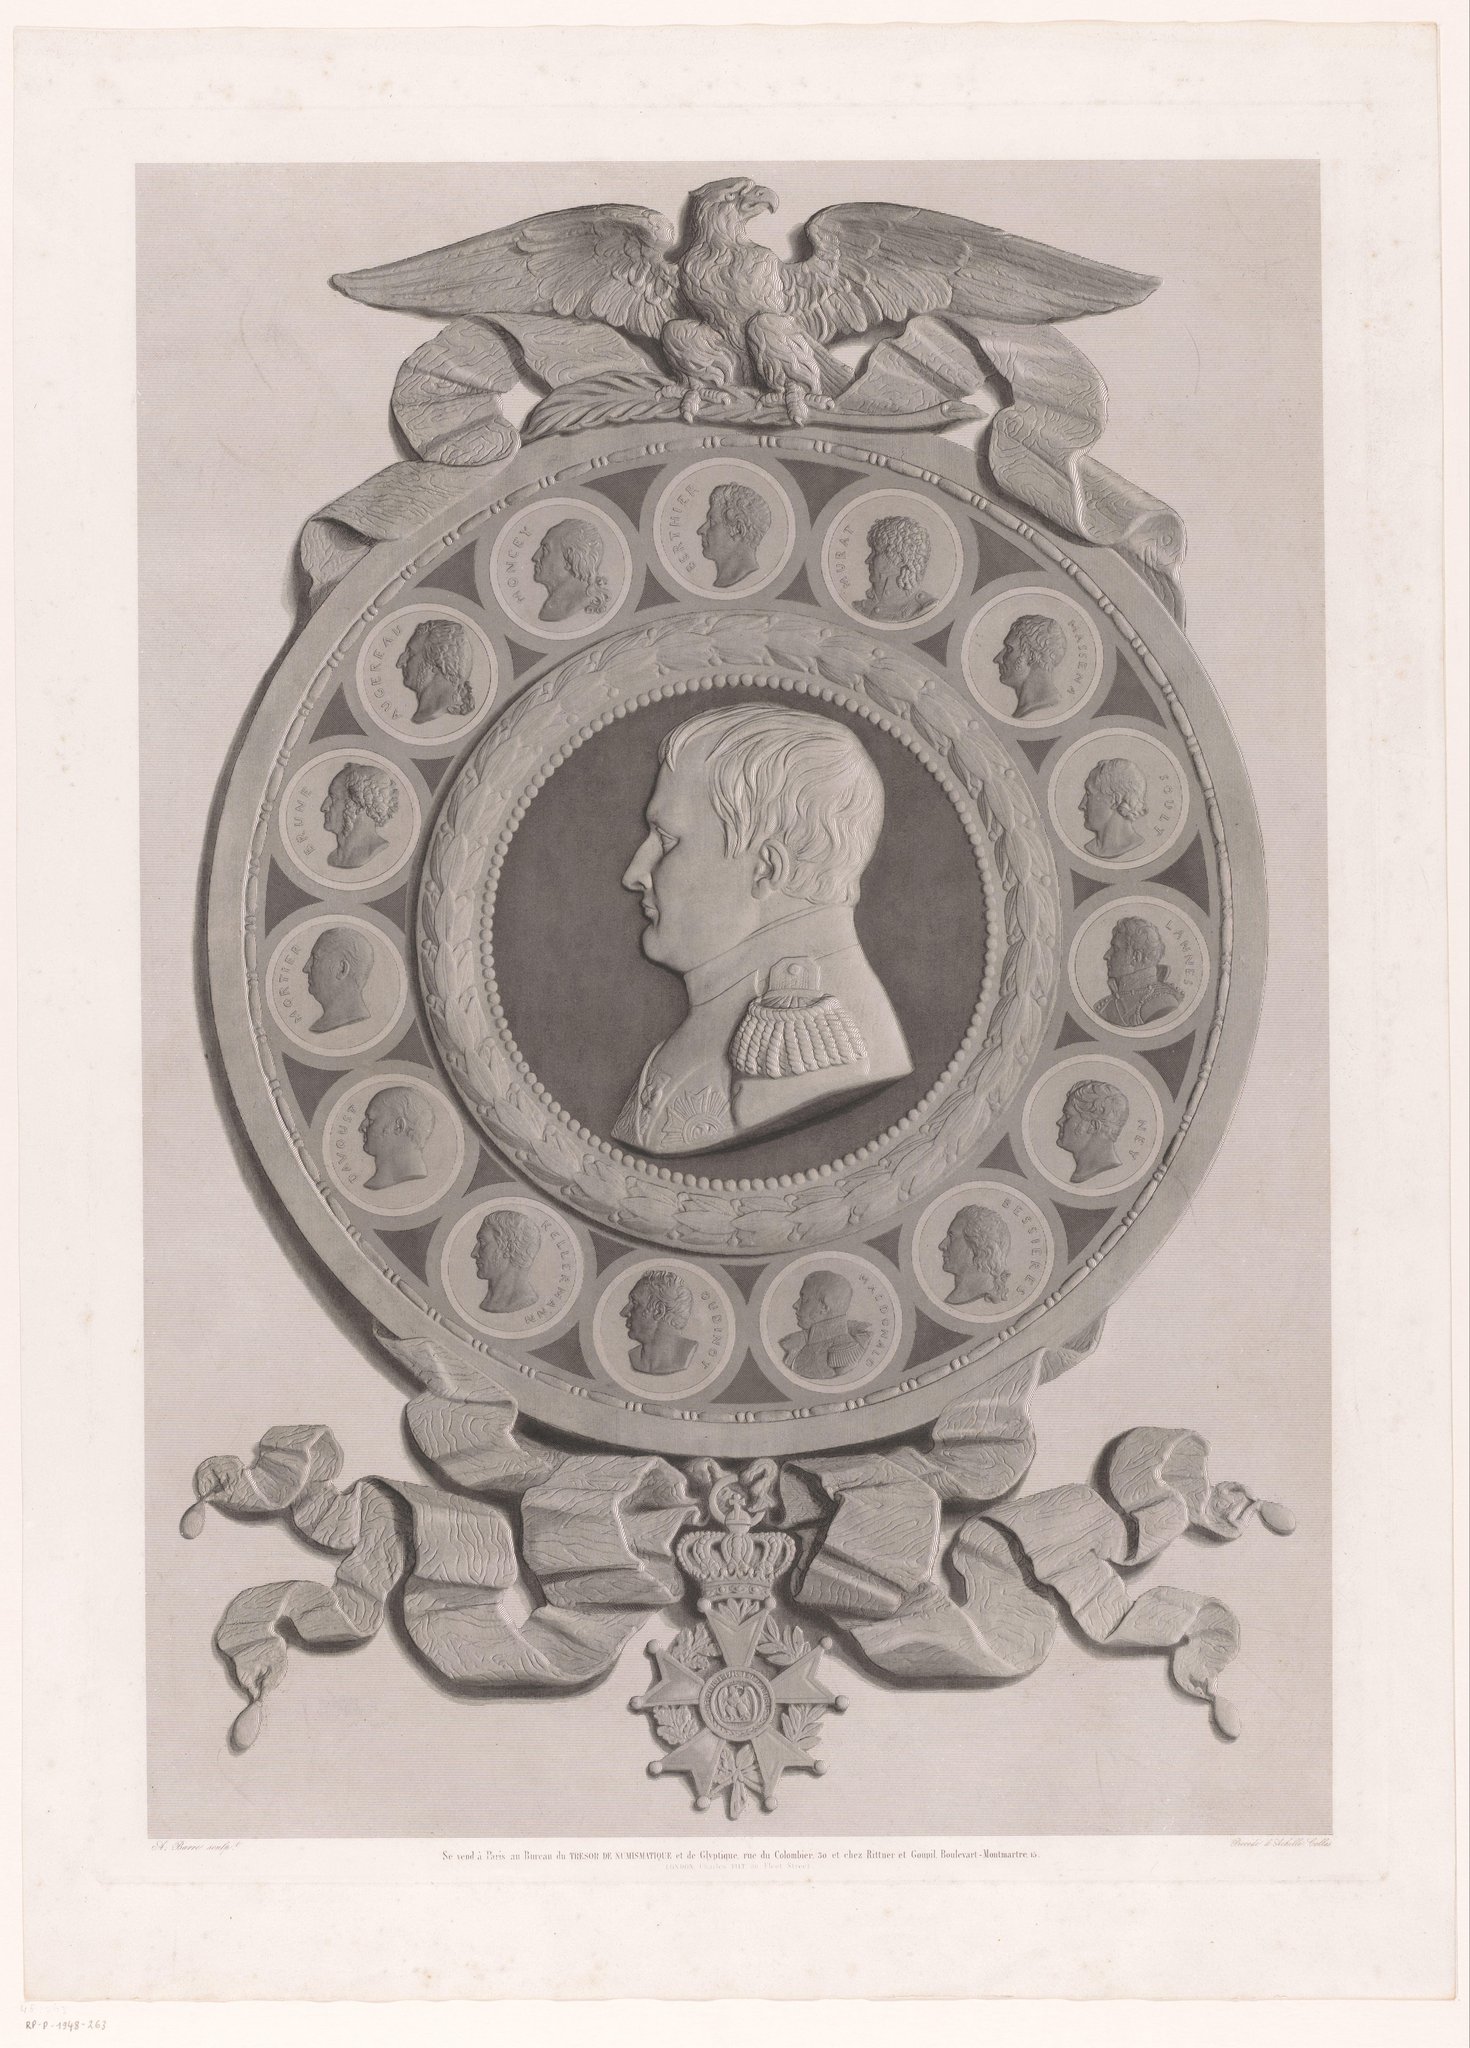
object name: print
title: Medaillon met portret van Napoleon Bonaparte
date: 1807-1861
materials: paper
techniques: relief engraving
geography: london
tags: napoleon i (emperor of the french), historical persons, medal (considered as a piece of sculpture, regardless of its specific function), emperor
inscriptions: collector's mark: Lugt 2228